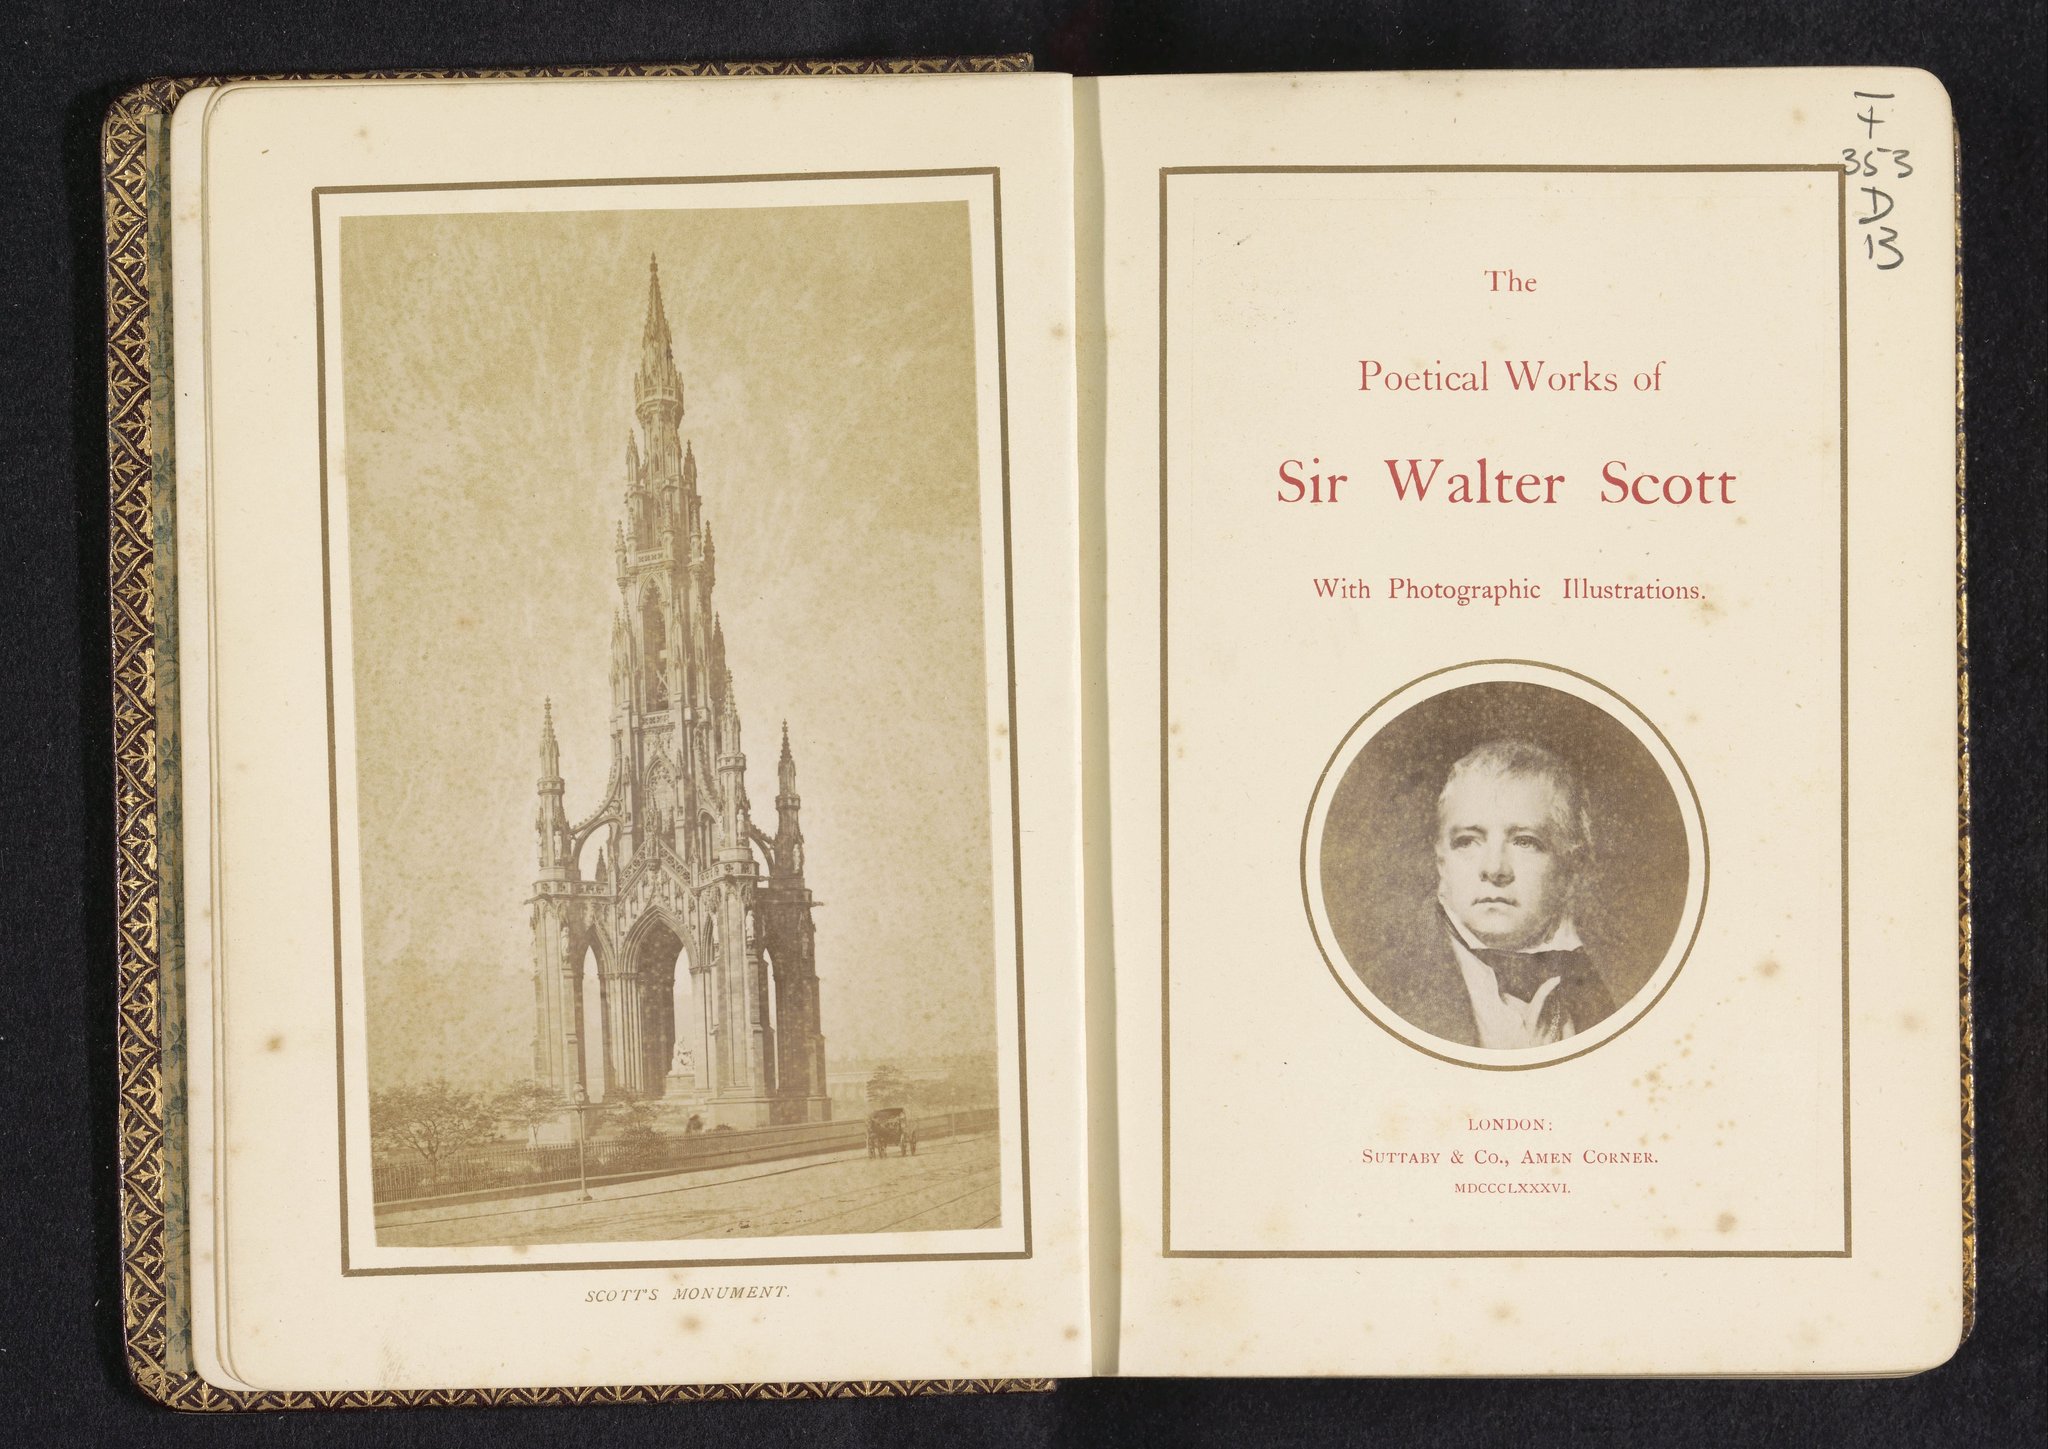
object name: photograph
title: The poetical works of Sir Walter Scott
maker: walter scott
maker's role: dichter, schrijver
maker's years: 1771-1832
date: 1886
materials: cardboard, leather, paper, photographic support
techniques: albumen print, printing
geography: london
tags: walter scott, writer, poet, author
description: Titelpagina met portret van Sir Walter Scott.